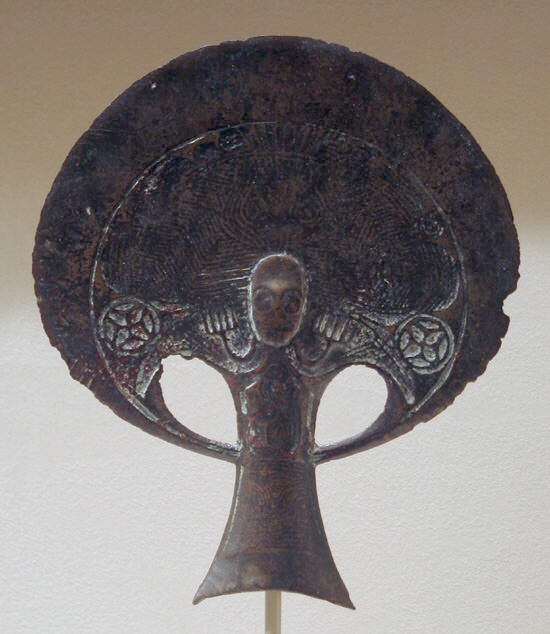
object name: ax head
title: Ax Head with Human Body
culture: indonesian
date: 500 BCE-300 CE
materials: bronze